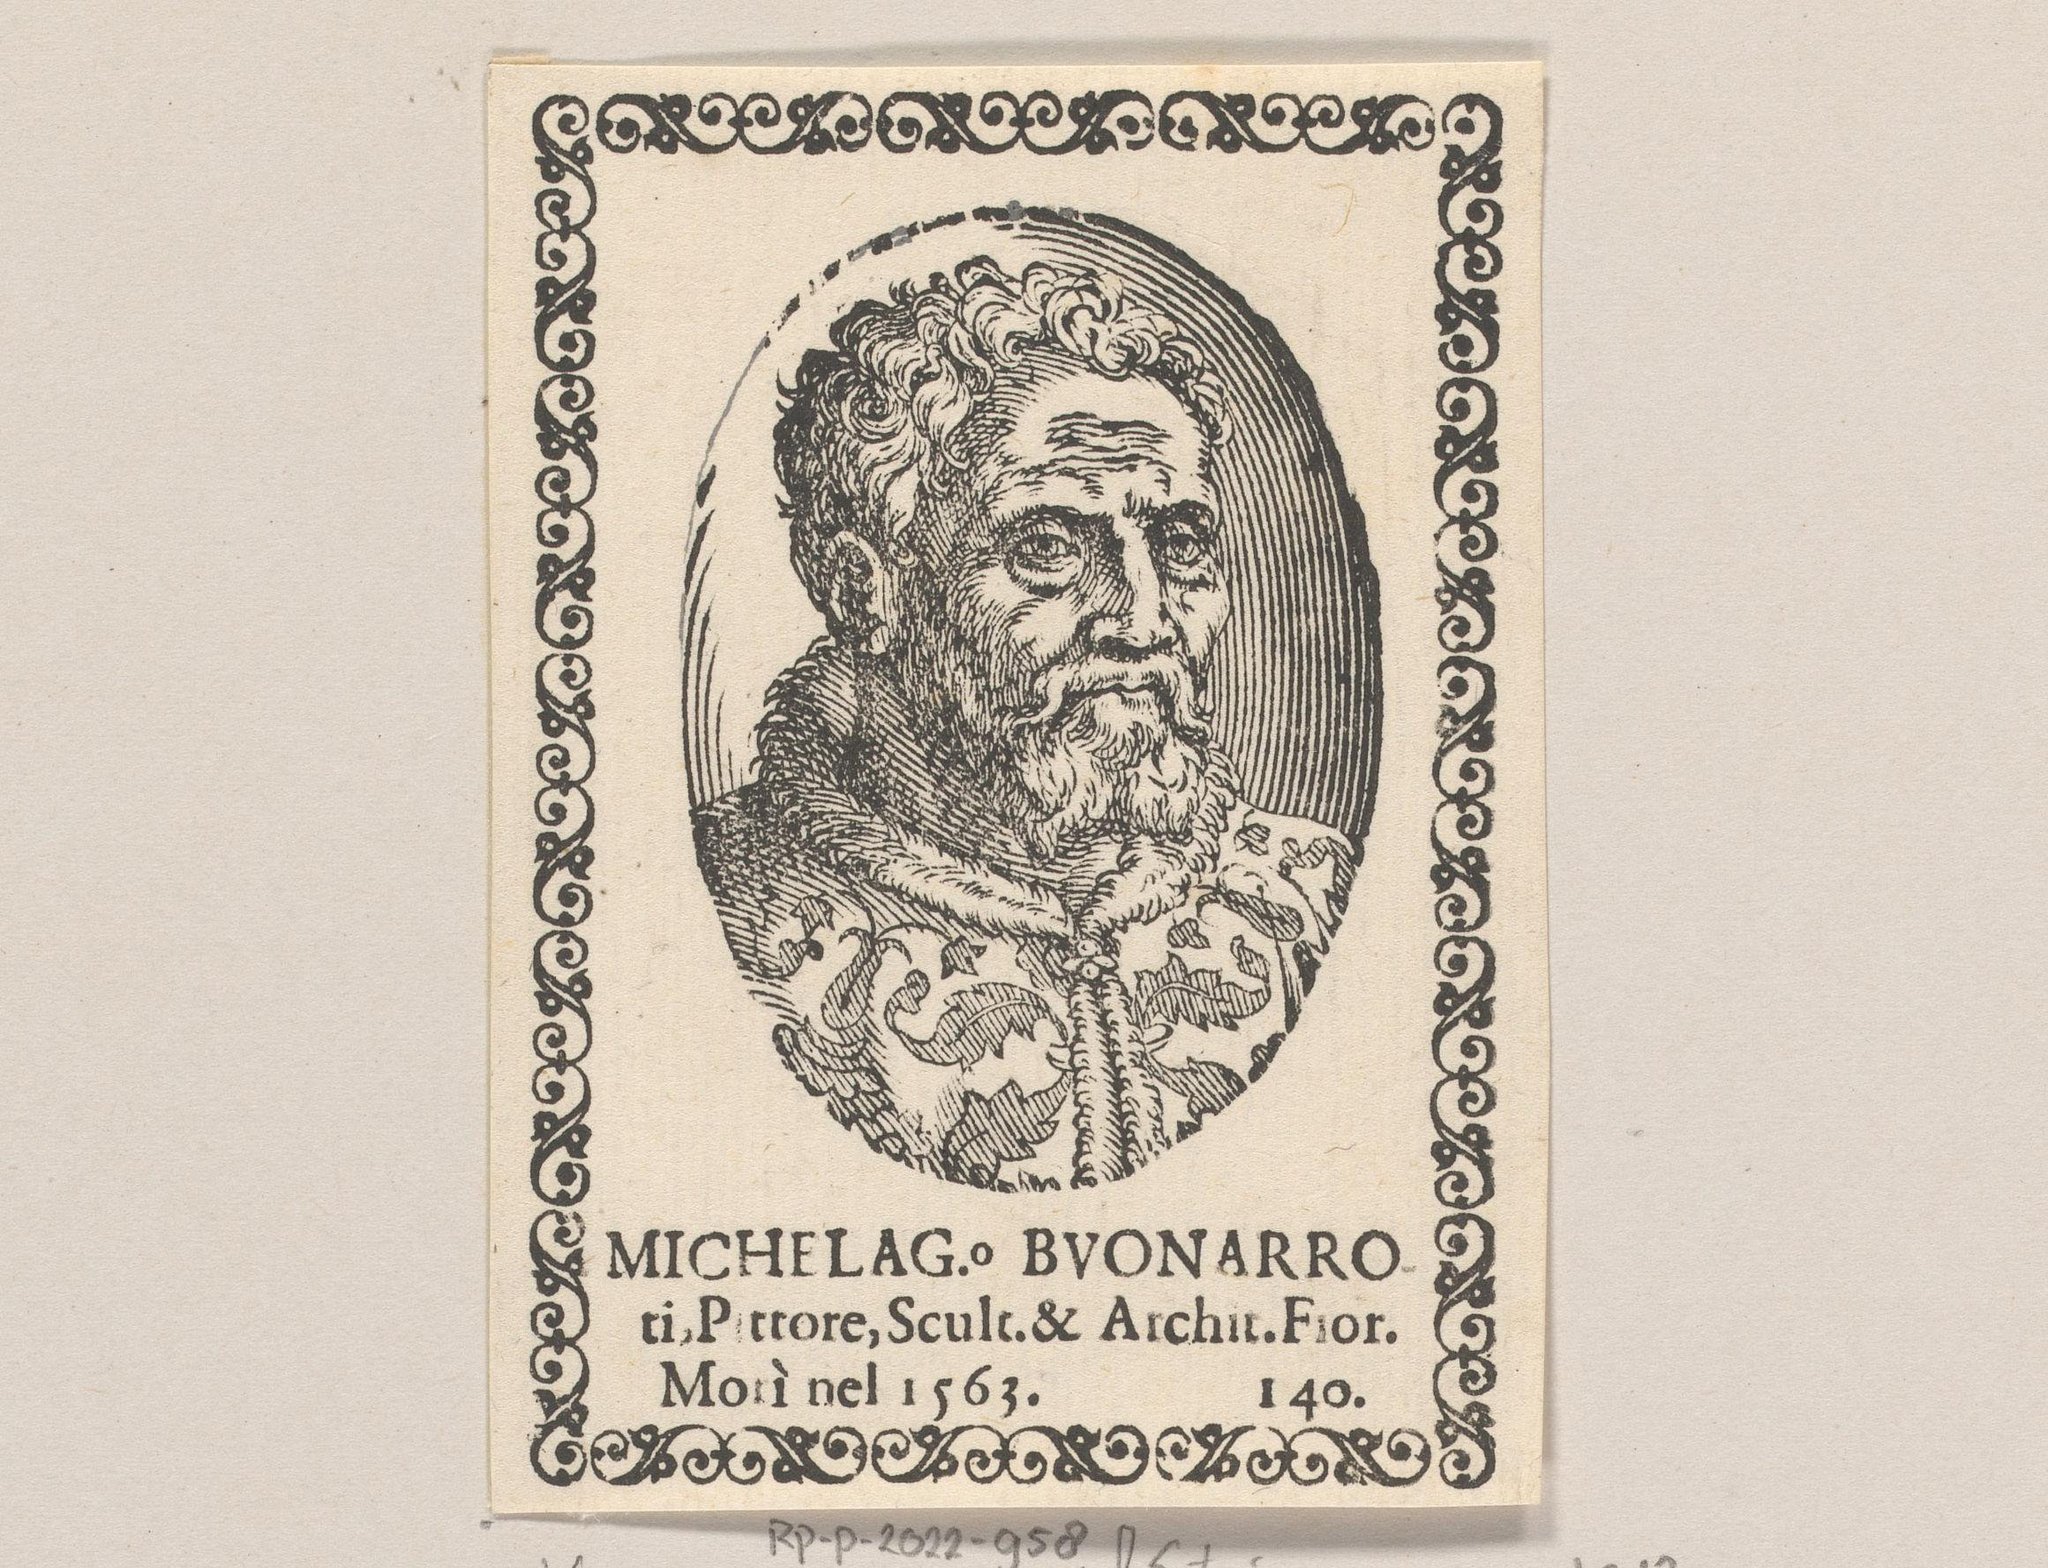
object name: book illustration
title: Michelag.o Buonarro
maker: Anonymous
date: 1568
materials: paper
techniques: letterpress printing, engraving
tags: rome, painter, draughtsman, sculptor, michelangelo, historical persons, portrait, self-portrait of artist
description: Prent waarschijnlijk uit: Vasari, Giorgio. Le Vite de' più eccellenti pittori, scultori, e architettori da Cimabue insino a' tempi nostri. Florence: Giunti, 1568.